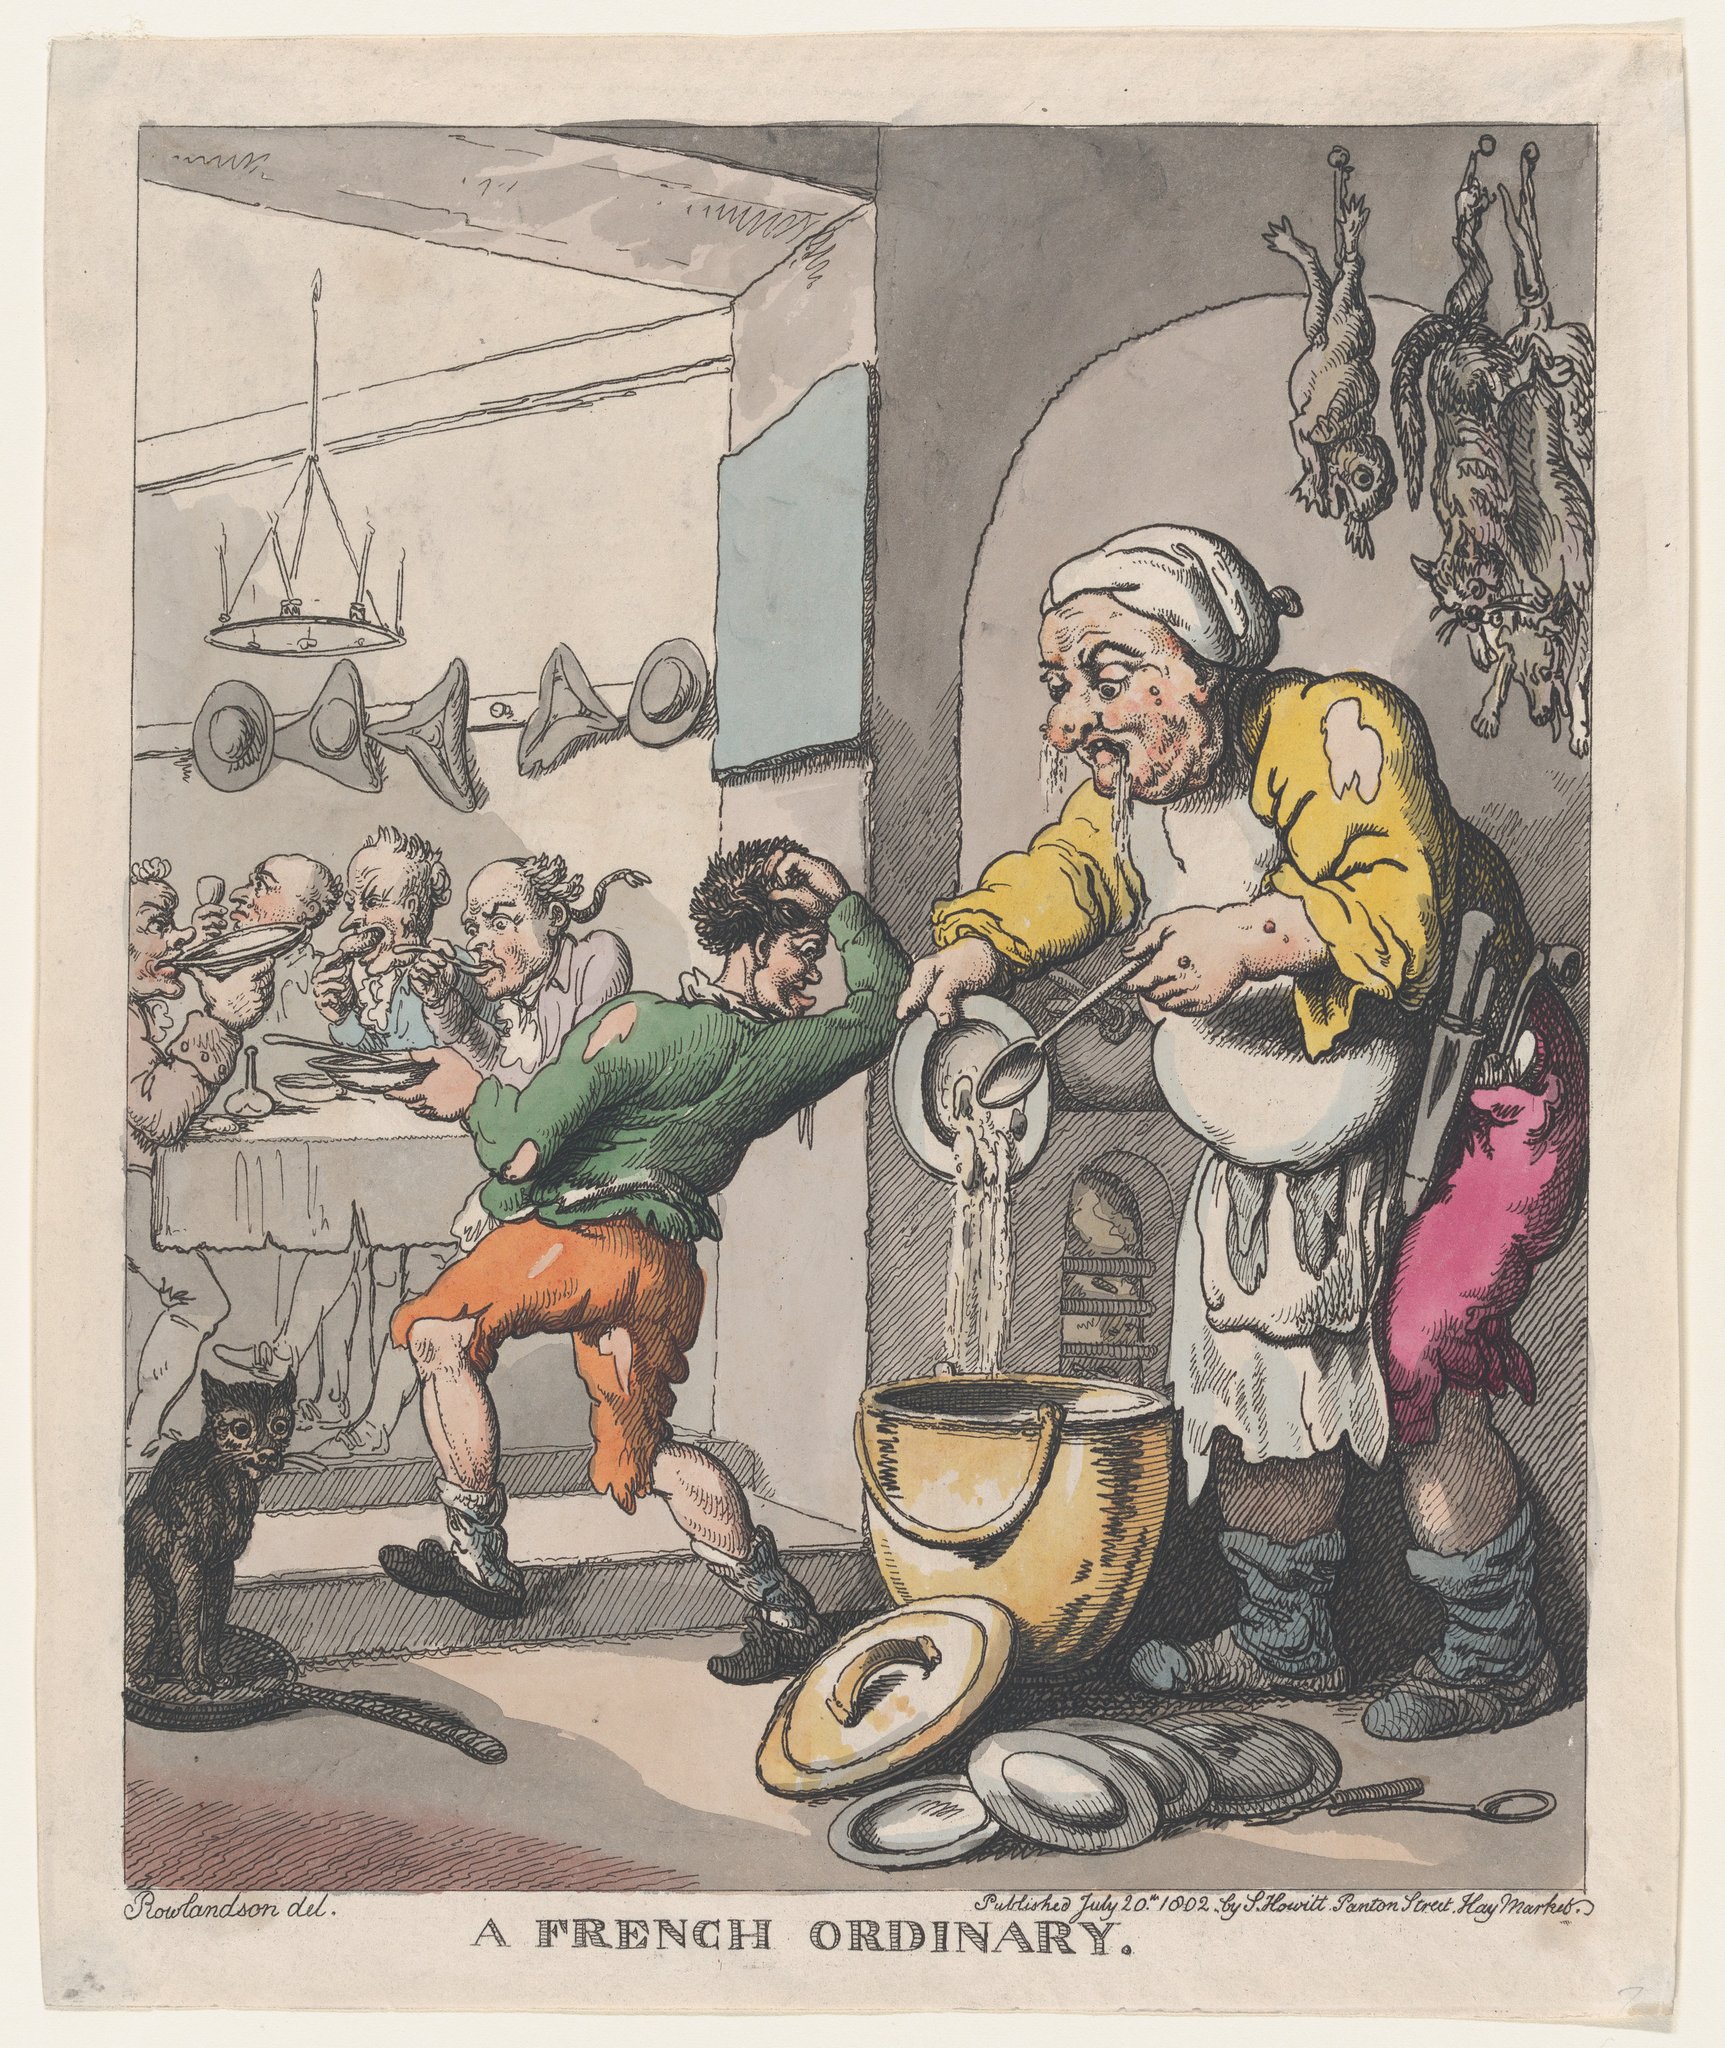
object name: print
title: A French Ordinary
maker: thomas rowlandson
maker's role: artist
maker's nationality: british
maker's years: 1757-1827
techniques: etching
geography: england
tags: food,satire,men,cats,dining,cooking